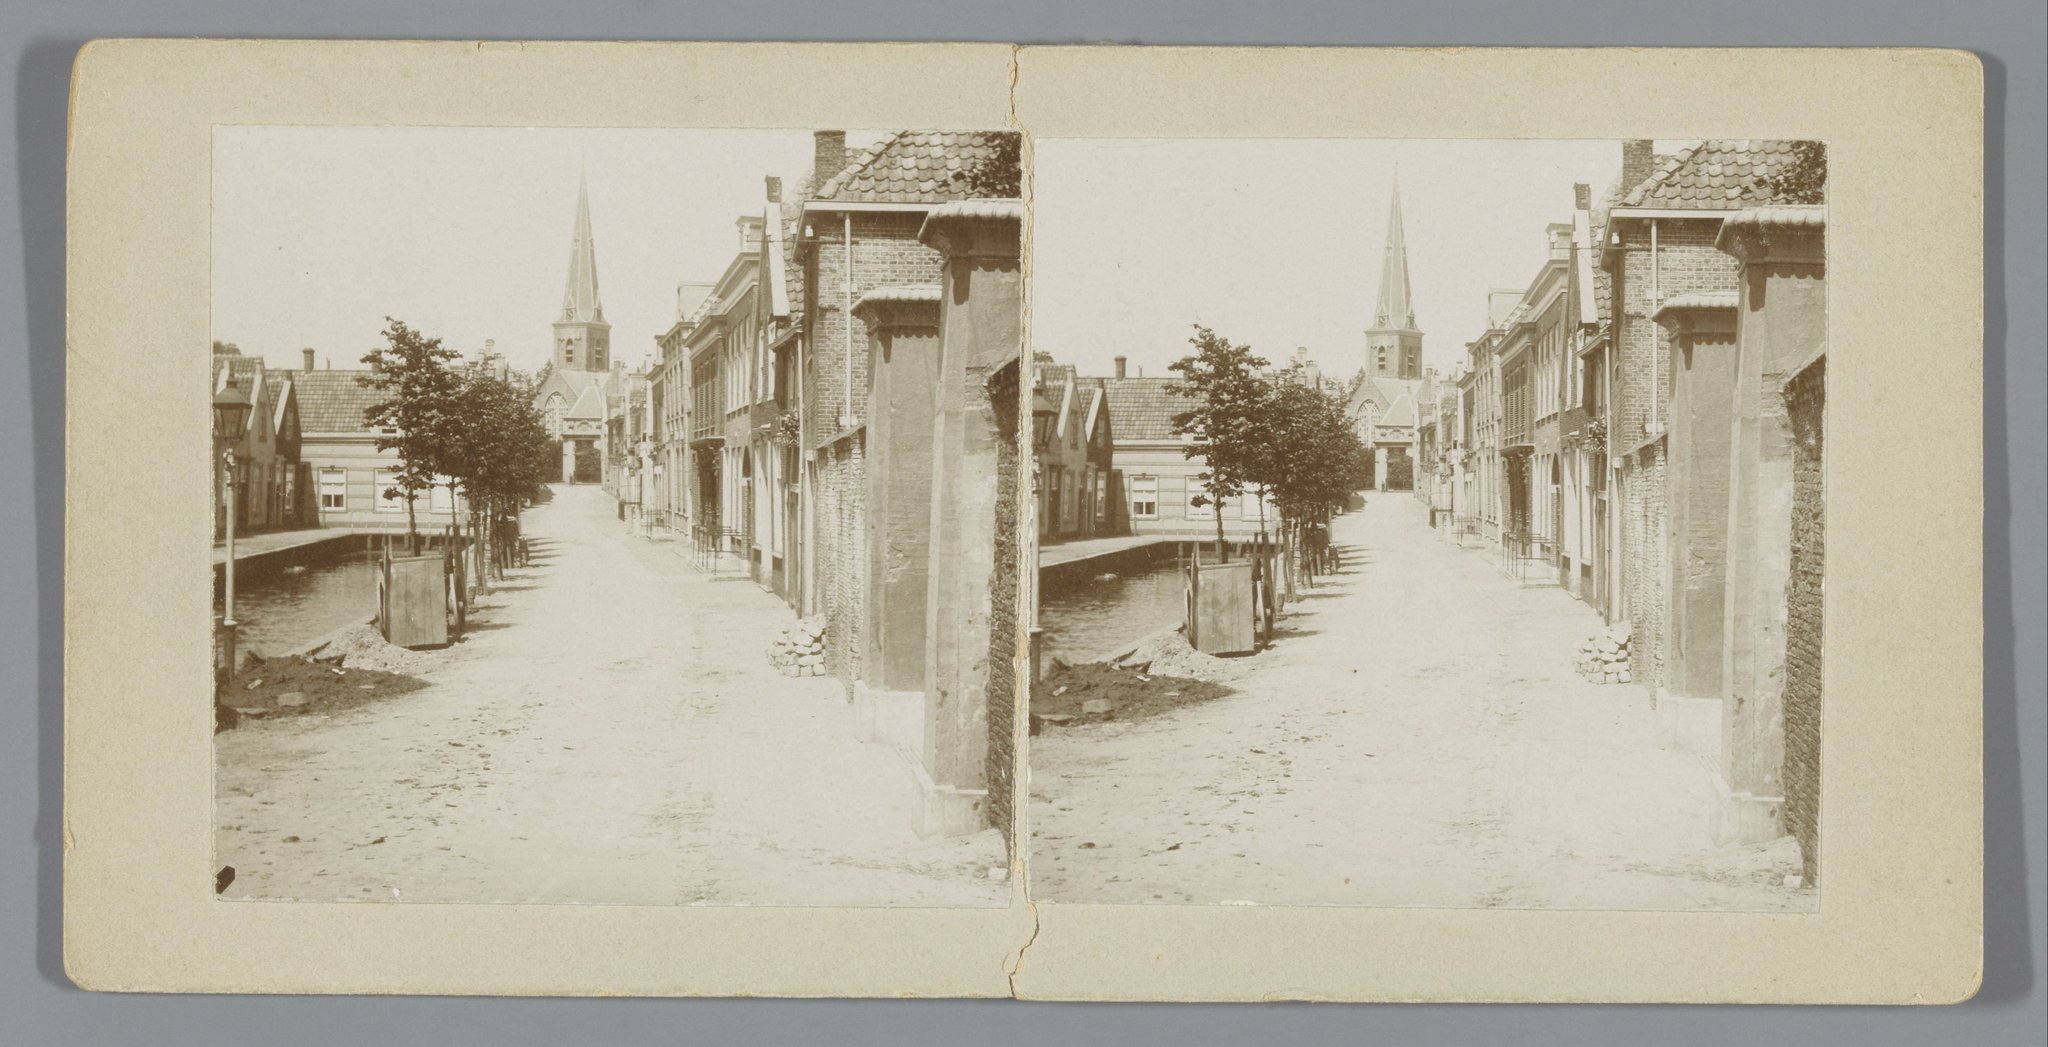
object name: stereograph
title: Straat in Voorburg langs buitenplaats Rusthof, in de verte de Oude of Martinikerk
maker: Anonymous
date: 1897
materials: paper, cardboard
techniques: collodion silver print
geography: voorburg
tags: protestant churches and denominations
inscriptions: inscription: ‘Voorburg, langs de Buiten van prinses Mariane met de/ Ned: Hervormde Kerk aan de Regterzijde te Zien. 1897’, inscription: ‘voorburg-’, monogram: ‘JK’